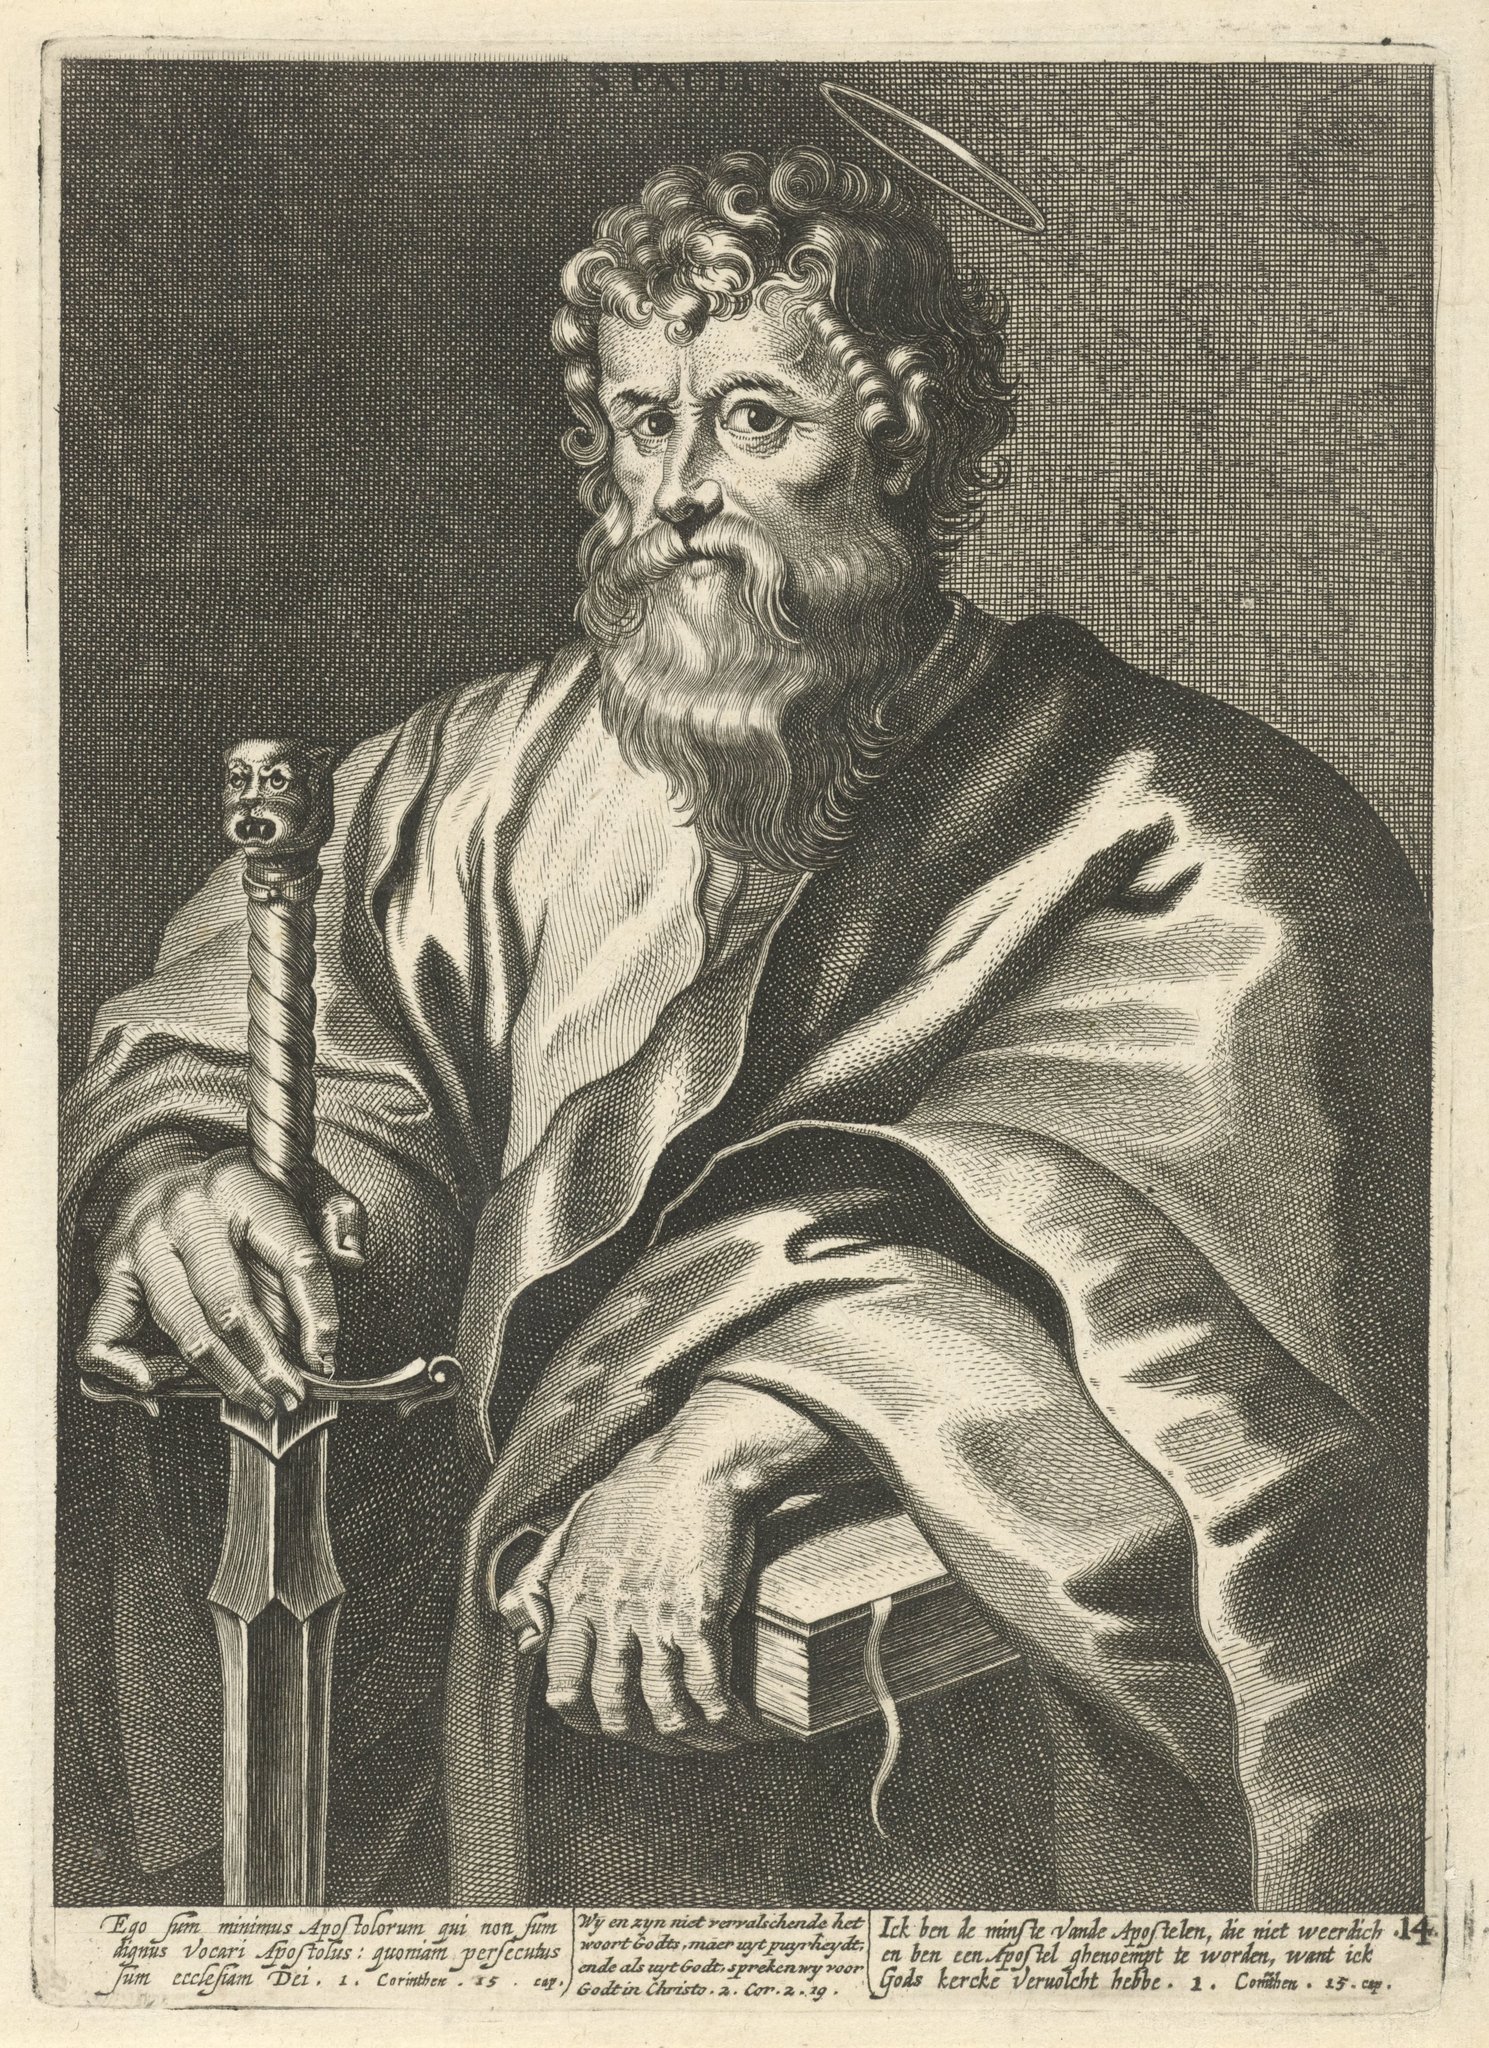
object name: print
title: Apostel Paulus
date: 1717-1732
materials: paper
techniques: engraving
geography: southern netherlands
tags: the apostle paul of tarsus; possible attributes: book, scroll, sword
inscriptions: collector's mark: Lugt 240